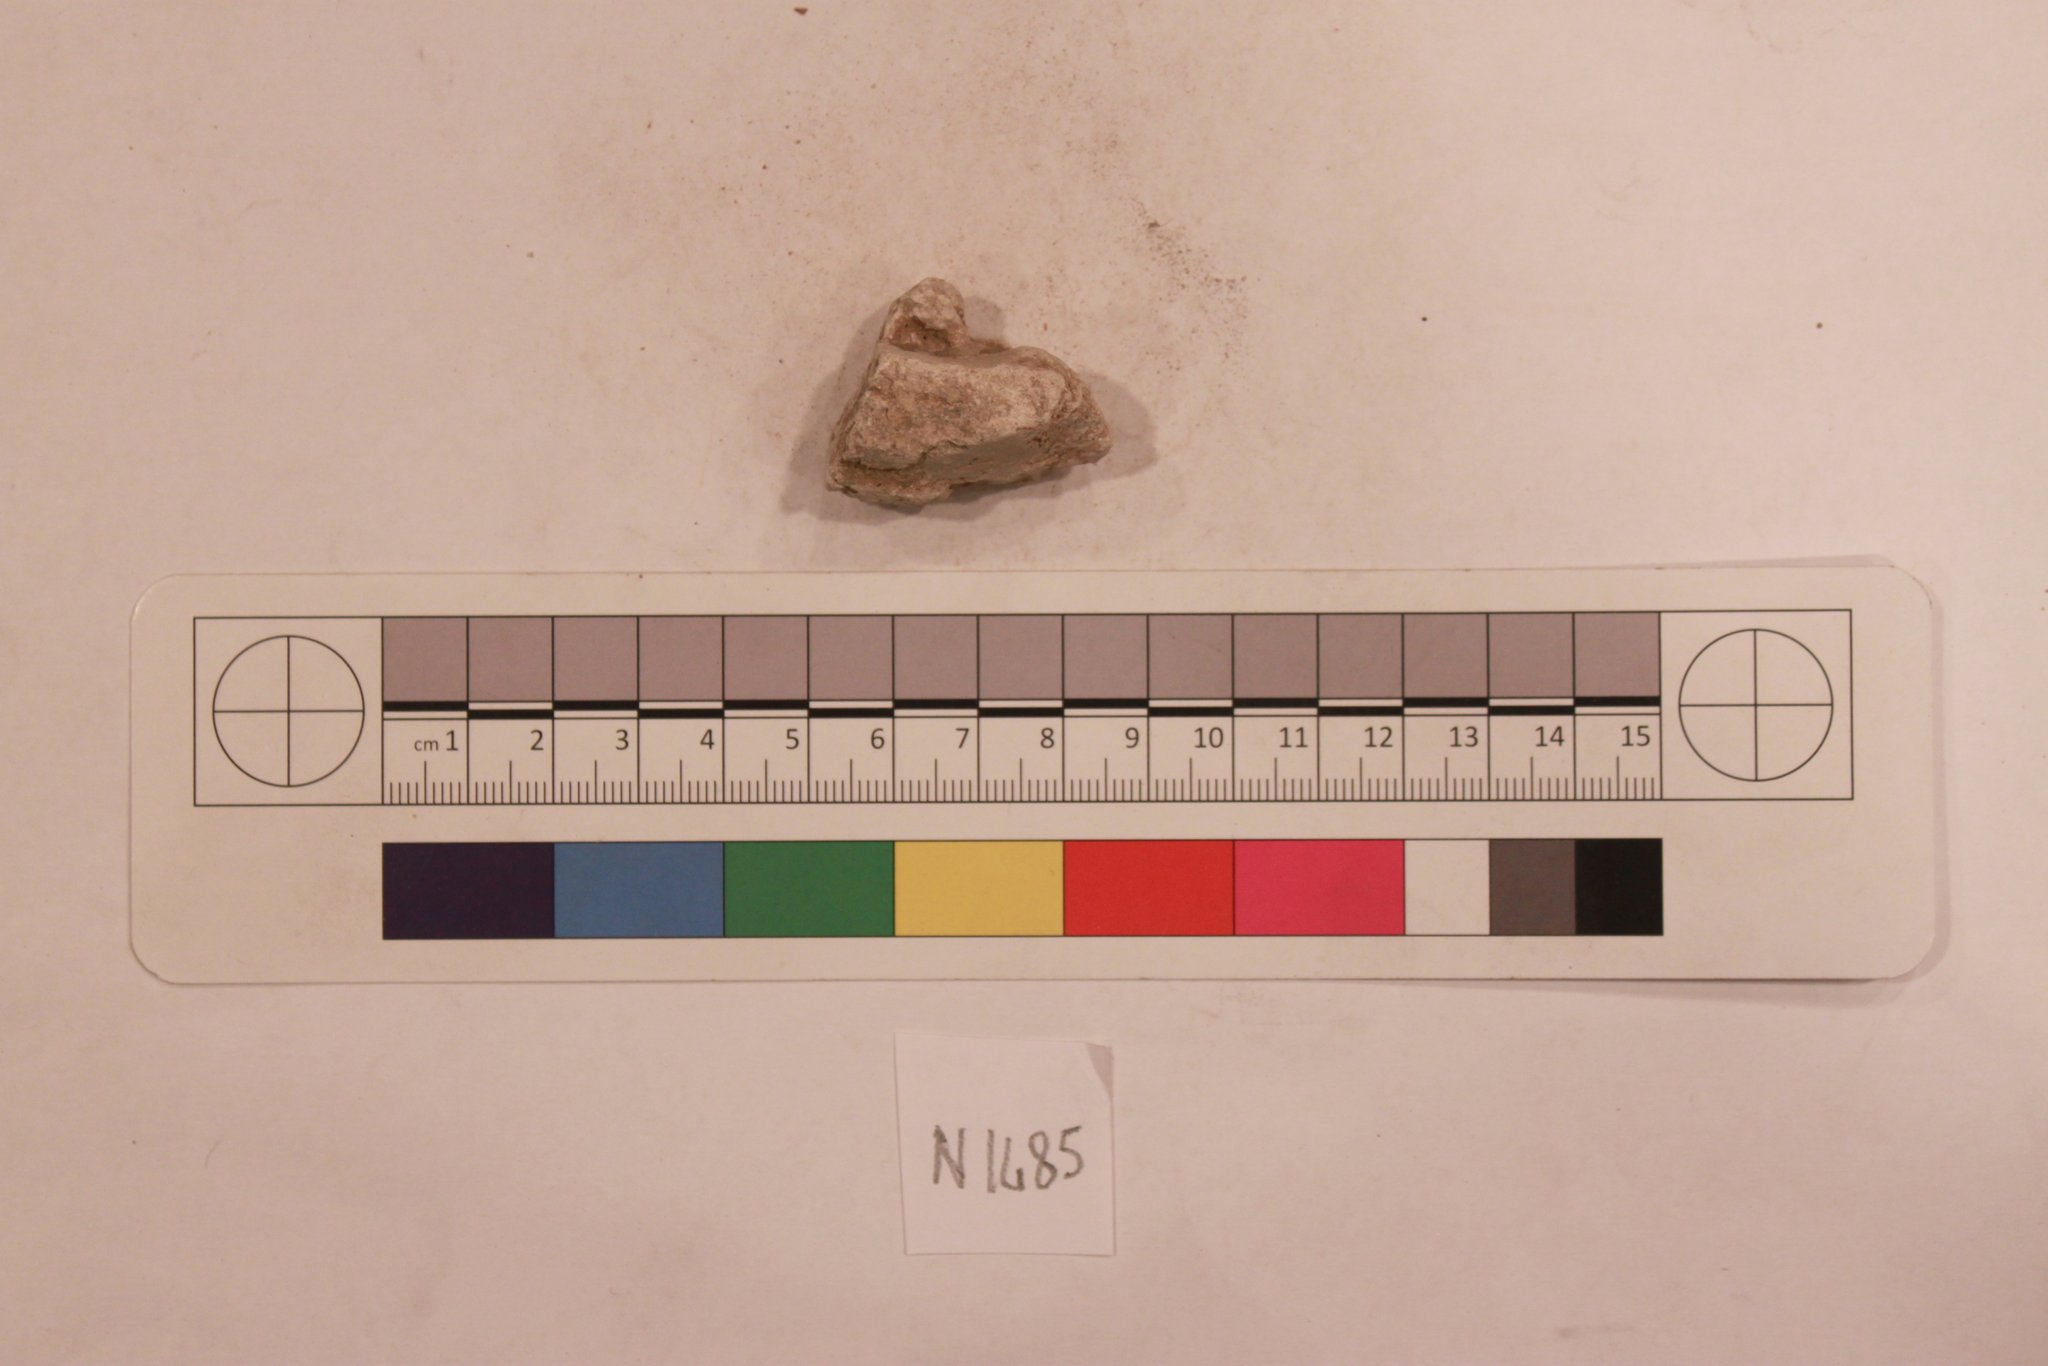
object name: fragment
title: Stucco Fragment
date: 701-1200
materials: plaster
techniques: carving, painting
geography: iran